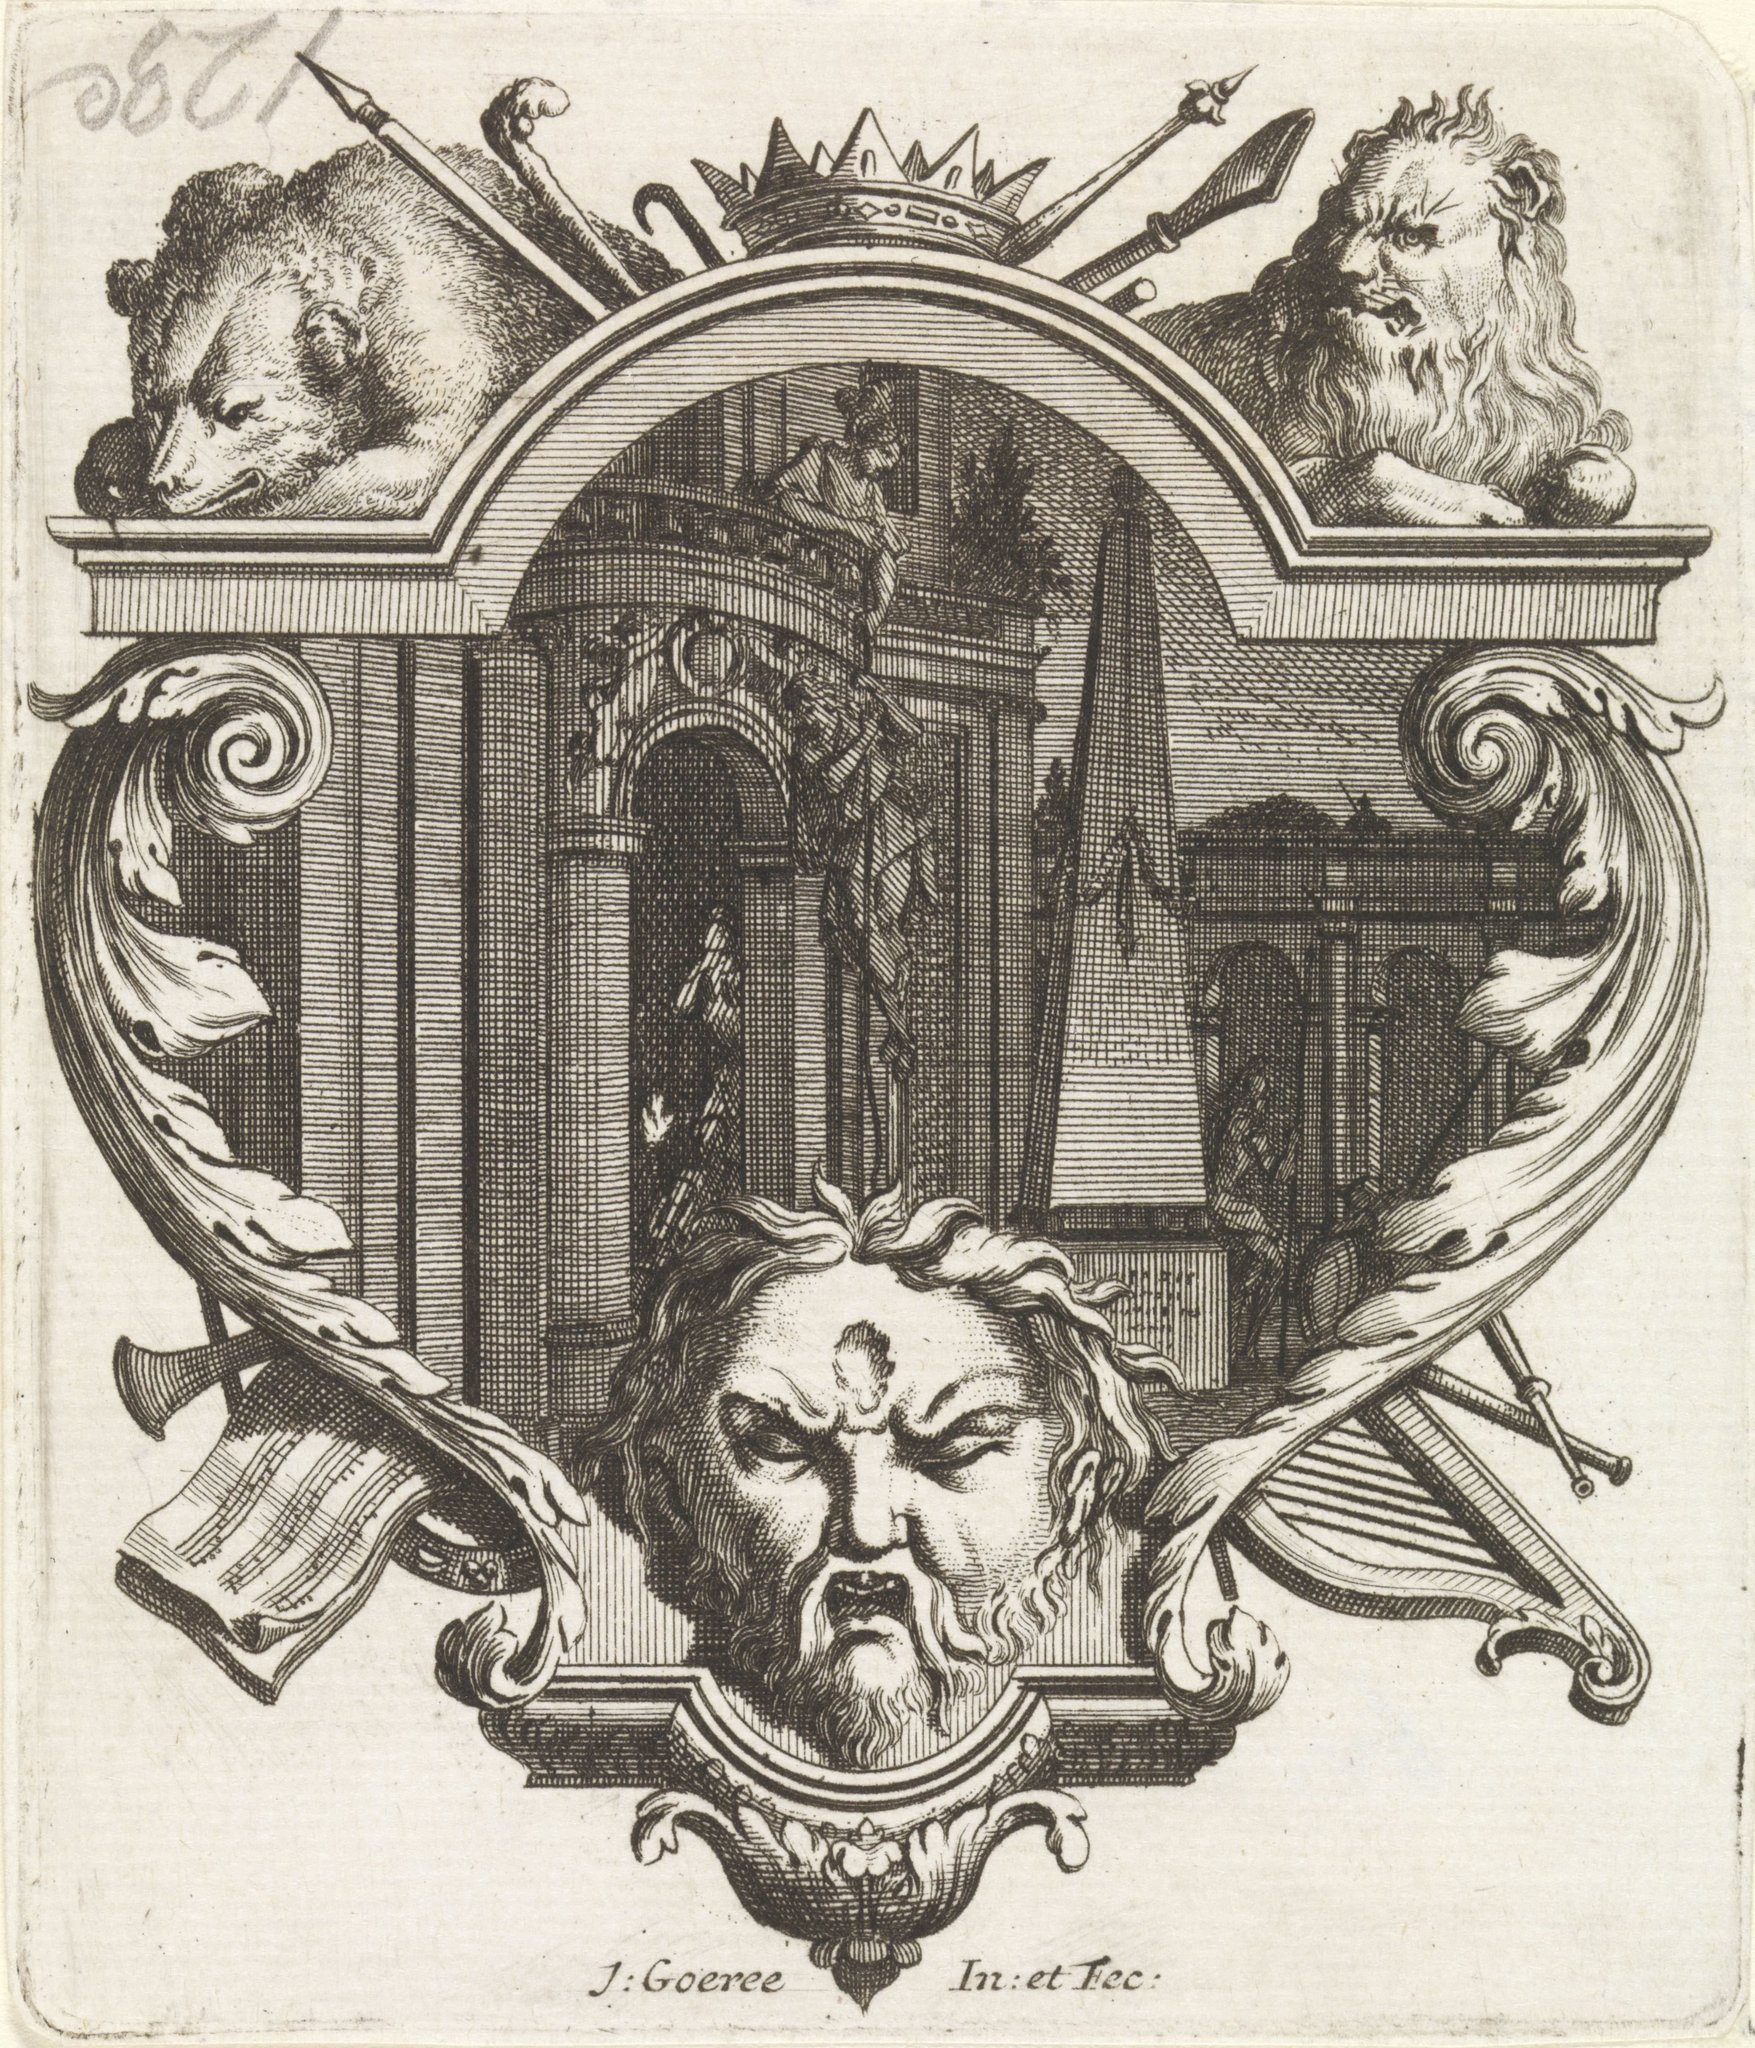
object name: print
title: Michal helpt David ontsnappen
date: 1710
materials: paper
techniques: engraving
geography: amsterdam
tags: david escapes through a window; michal lets him down with the help of a rope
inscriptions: collector's mark: Lugt 2228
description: Een ornamenteel kader. Michal, de dochter van Saul, helpt David ontsnappen aan de soldaten van haar vader. David klimt vanuit haar balkon via een touw naar onder.